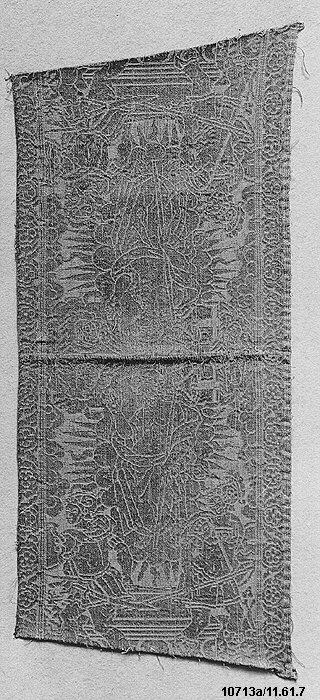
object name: orphrey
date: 1501-1600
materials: linen, metal thread, silk